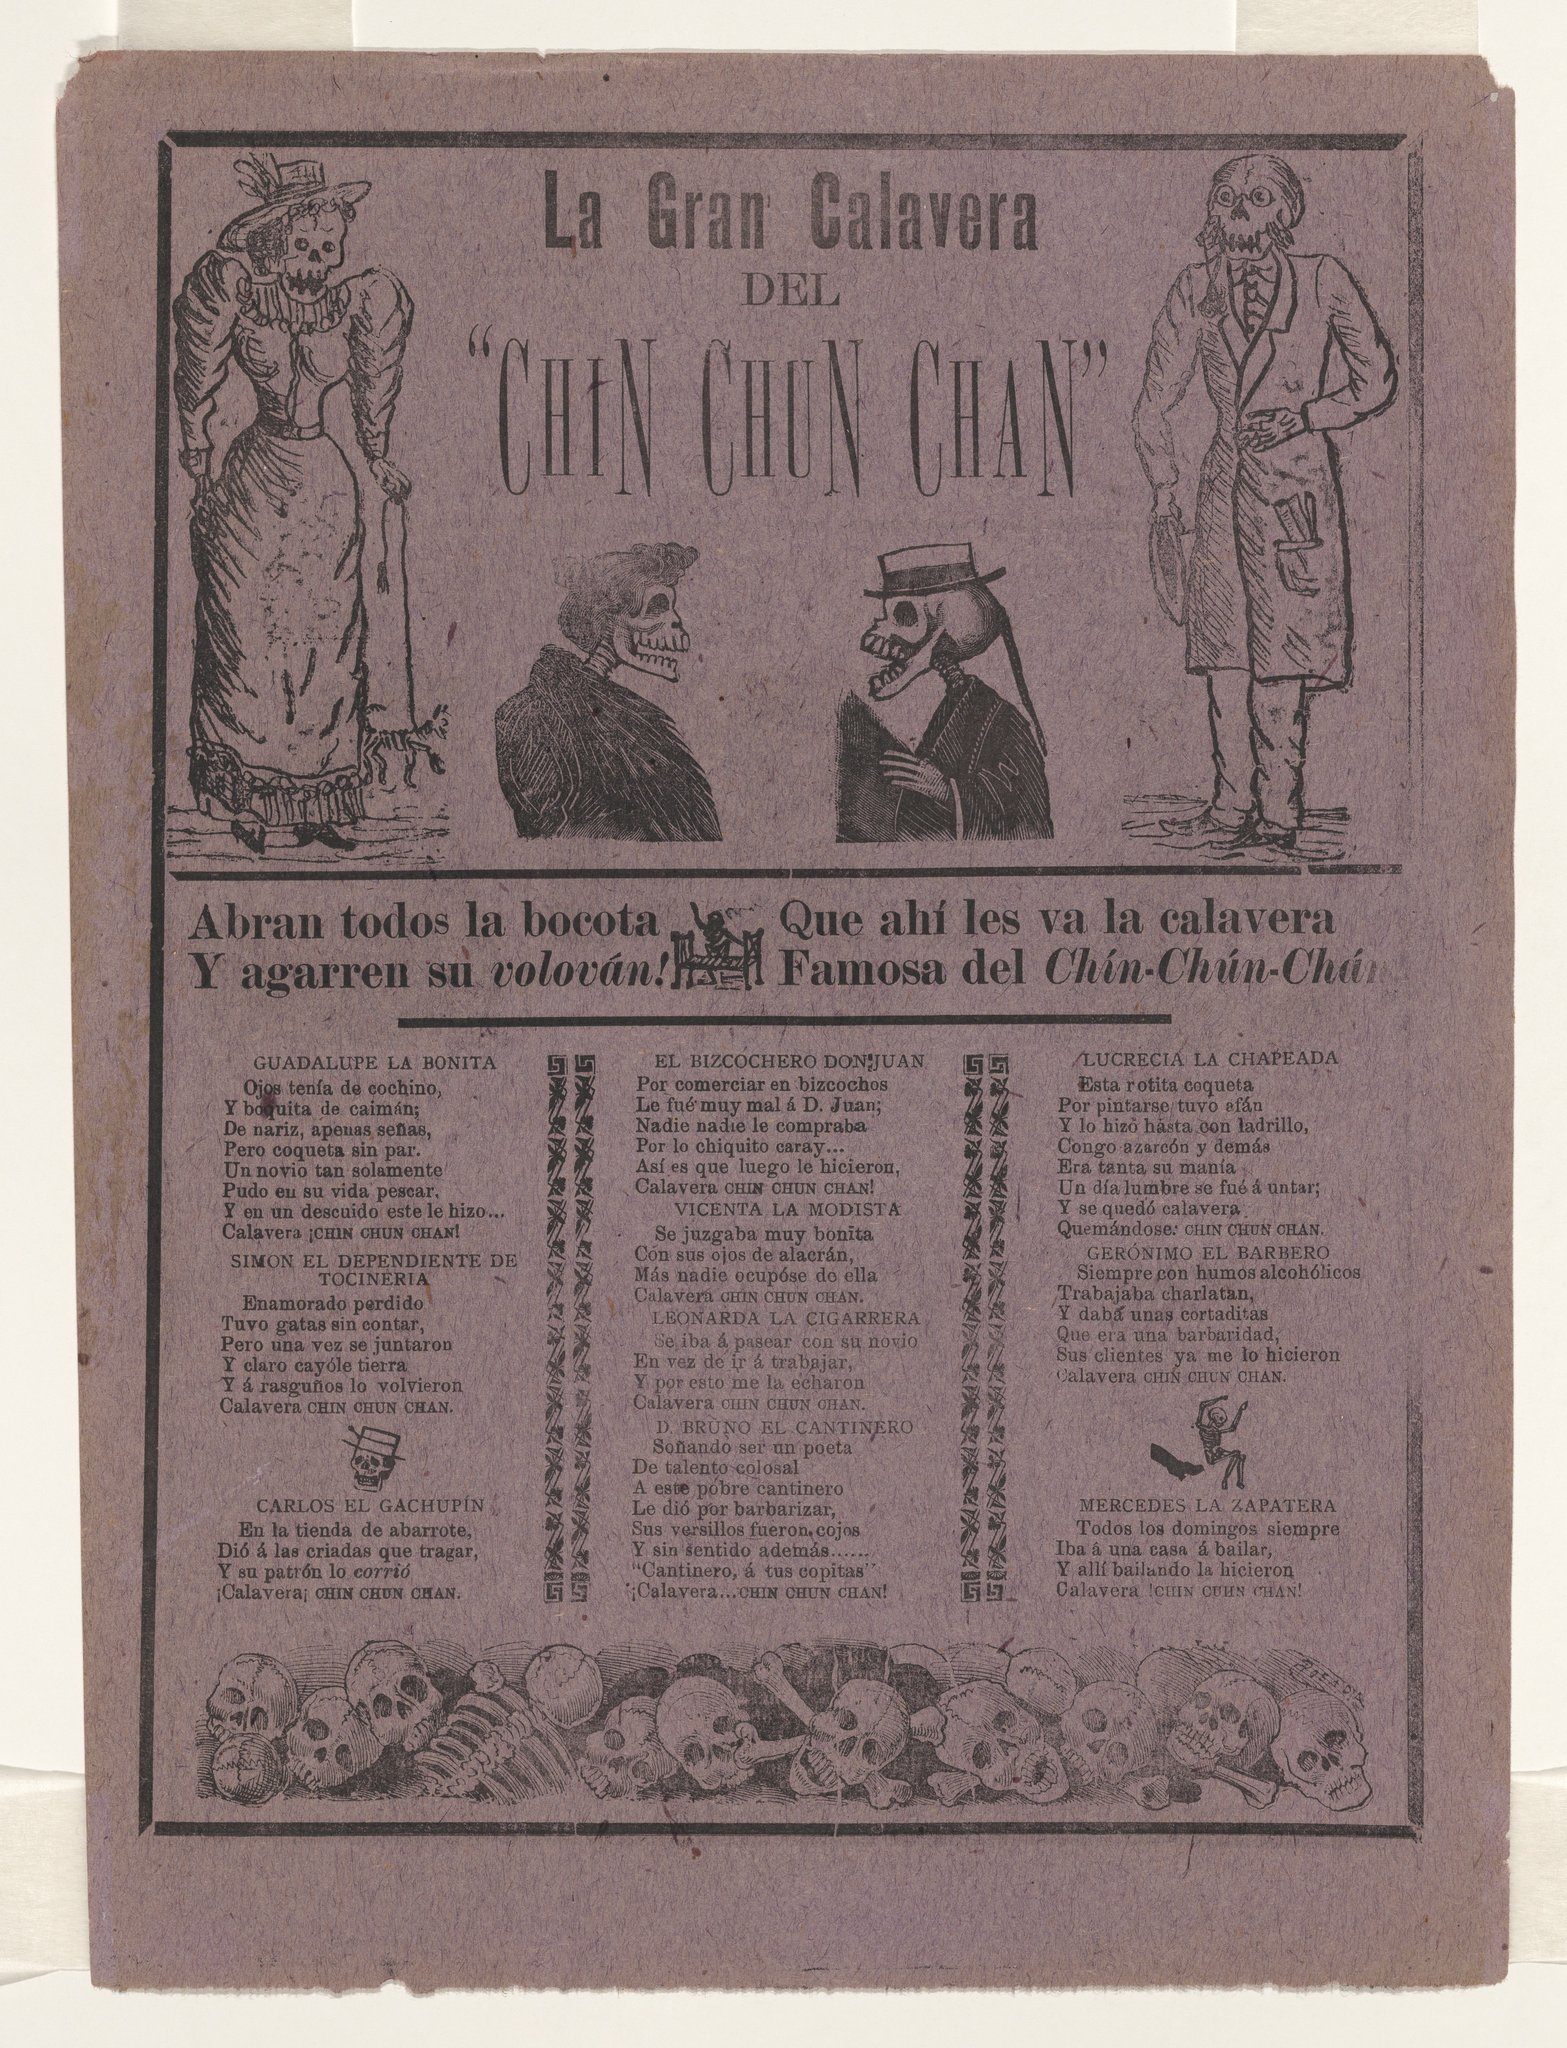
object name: print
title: Broadsheet relating to the great skeleton of the Chin-Chun-Chan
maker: josé guadalupe posada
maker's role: artist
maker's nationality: mexican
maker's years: 1852-1913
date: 1904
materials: metal, paper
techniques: engraving, letterpress, lithography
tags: skeletons